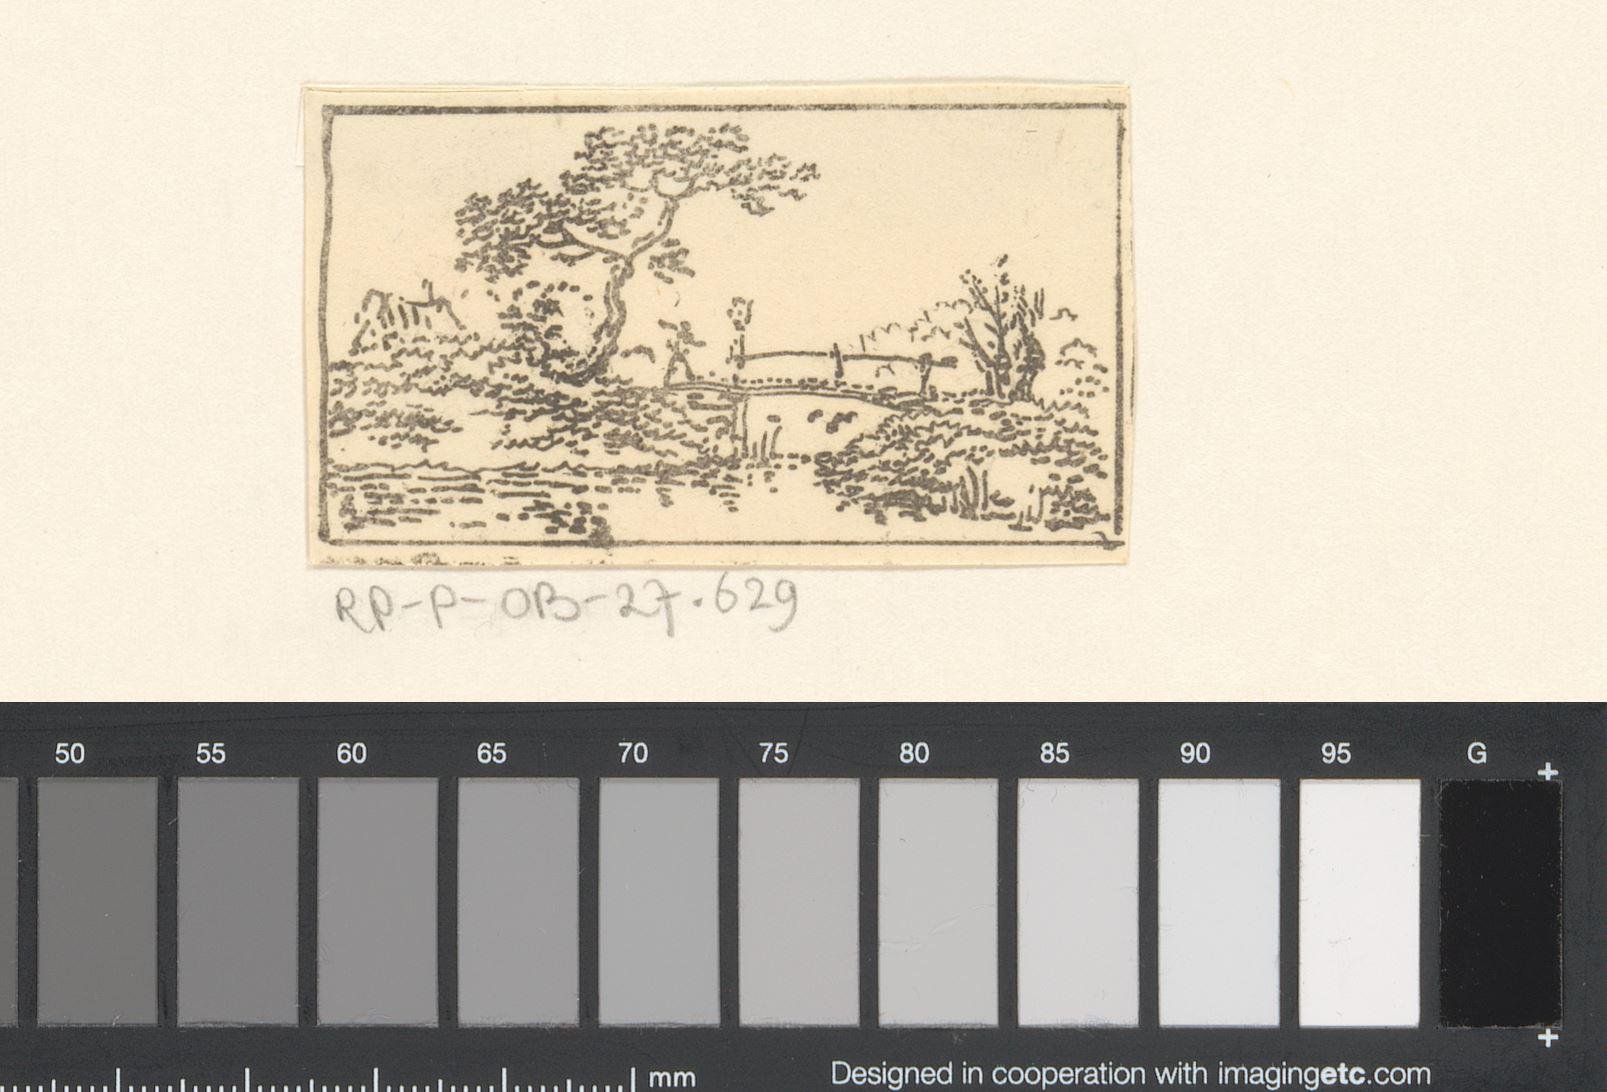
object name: print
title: Landschap met figuur op brug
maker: pieter bartholomeusz. barbiers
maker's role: draughtsman, print maker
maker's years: 1772-1837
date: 1815-1837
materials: paper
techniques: lithograph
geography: netherlands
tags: landscape with bridge, viaduct or aqueduct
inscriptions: collector's mark: Lugt 2228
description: Links een huis en grote boom. In het midden een rivier met daarover een brug. Links loopt een figuur de brug op.